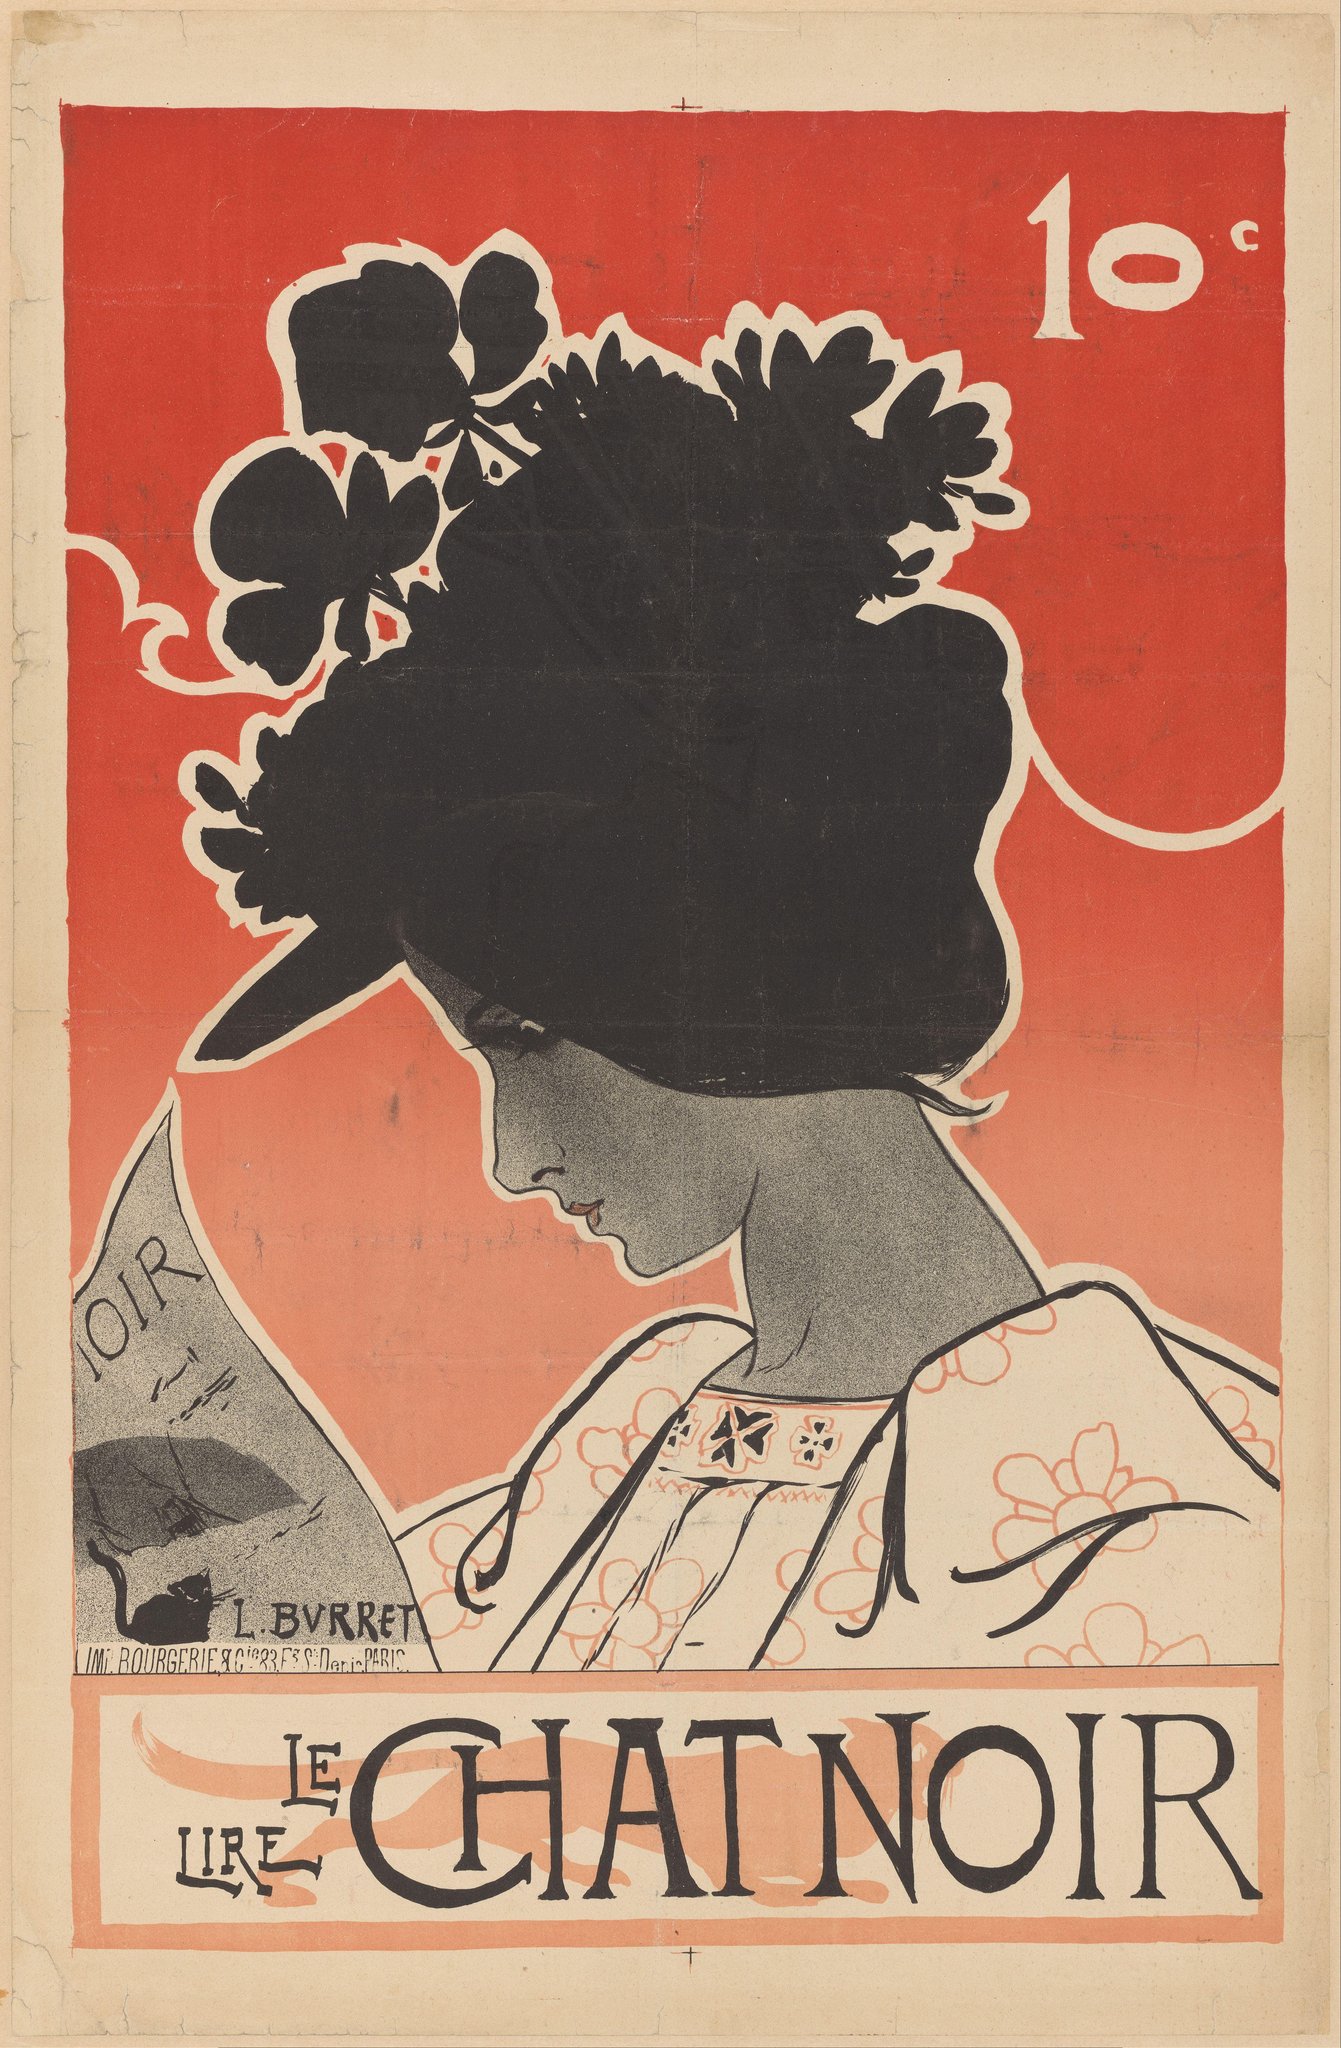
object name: poster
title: Affiche voor het tijdschrift Le Chat Noir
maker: léonce burret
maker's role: affiche-ontwerper, illustrator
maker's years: 1866-1915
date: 1882-1899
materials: paper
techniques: lithograph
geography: paris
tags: reading, weekly, monthly, magazine, etc.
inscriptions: collector's mark: Lugt 2228, collector's mark: Lugt 4779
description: Een vrouw met een hoed, lezend in een aflevering van Le Chat Noir.